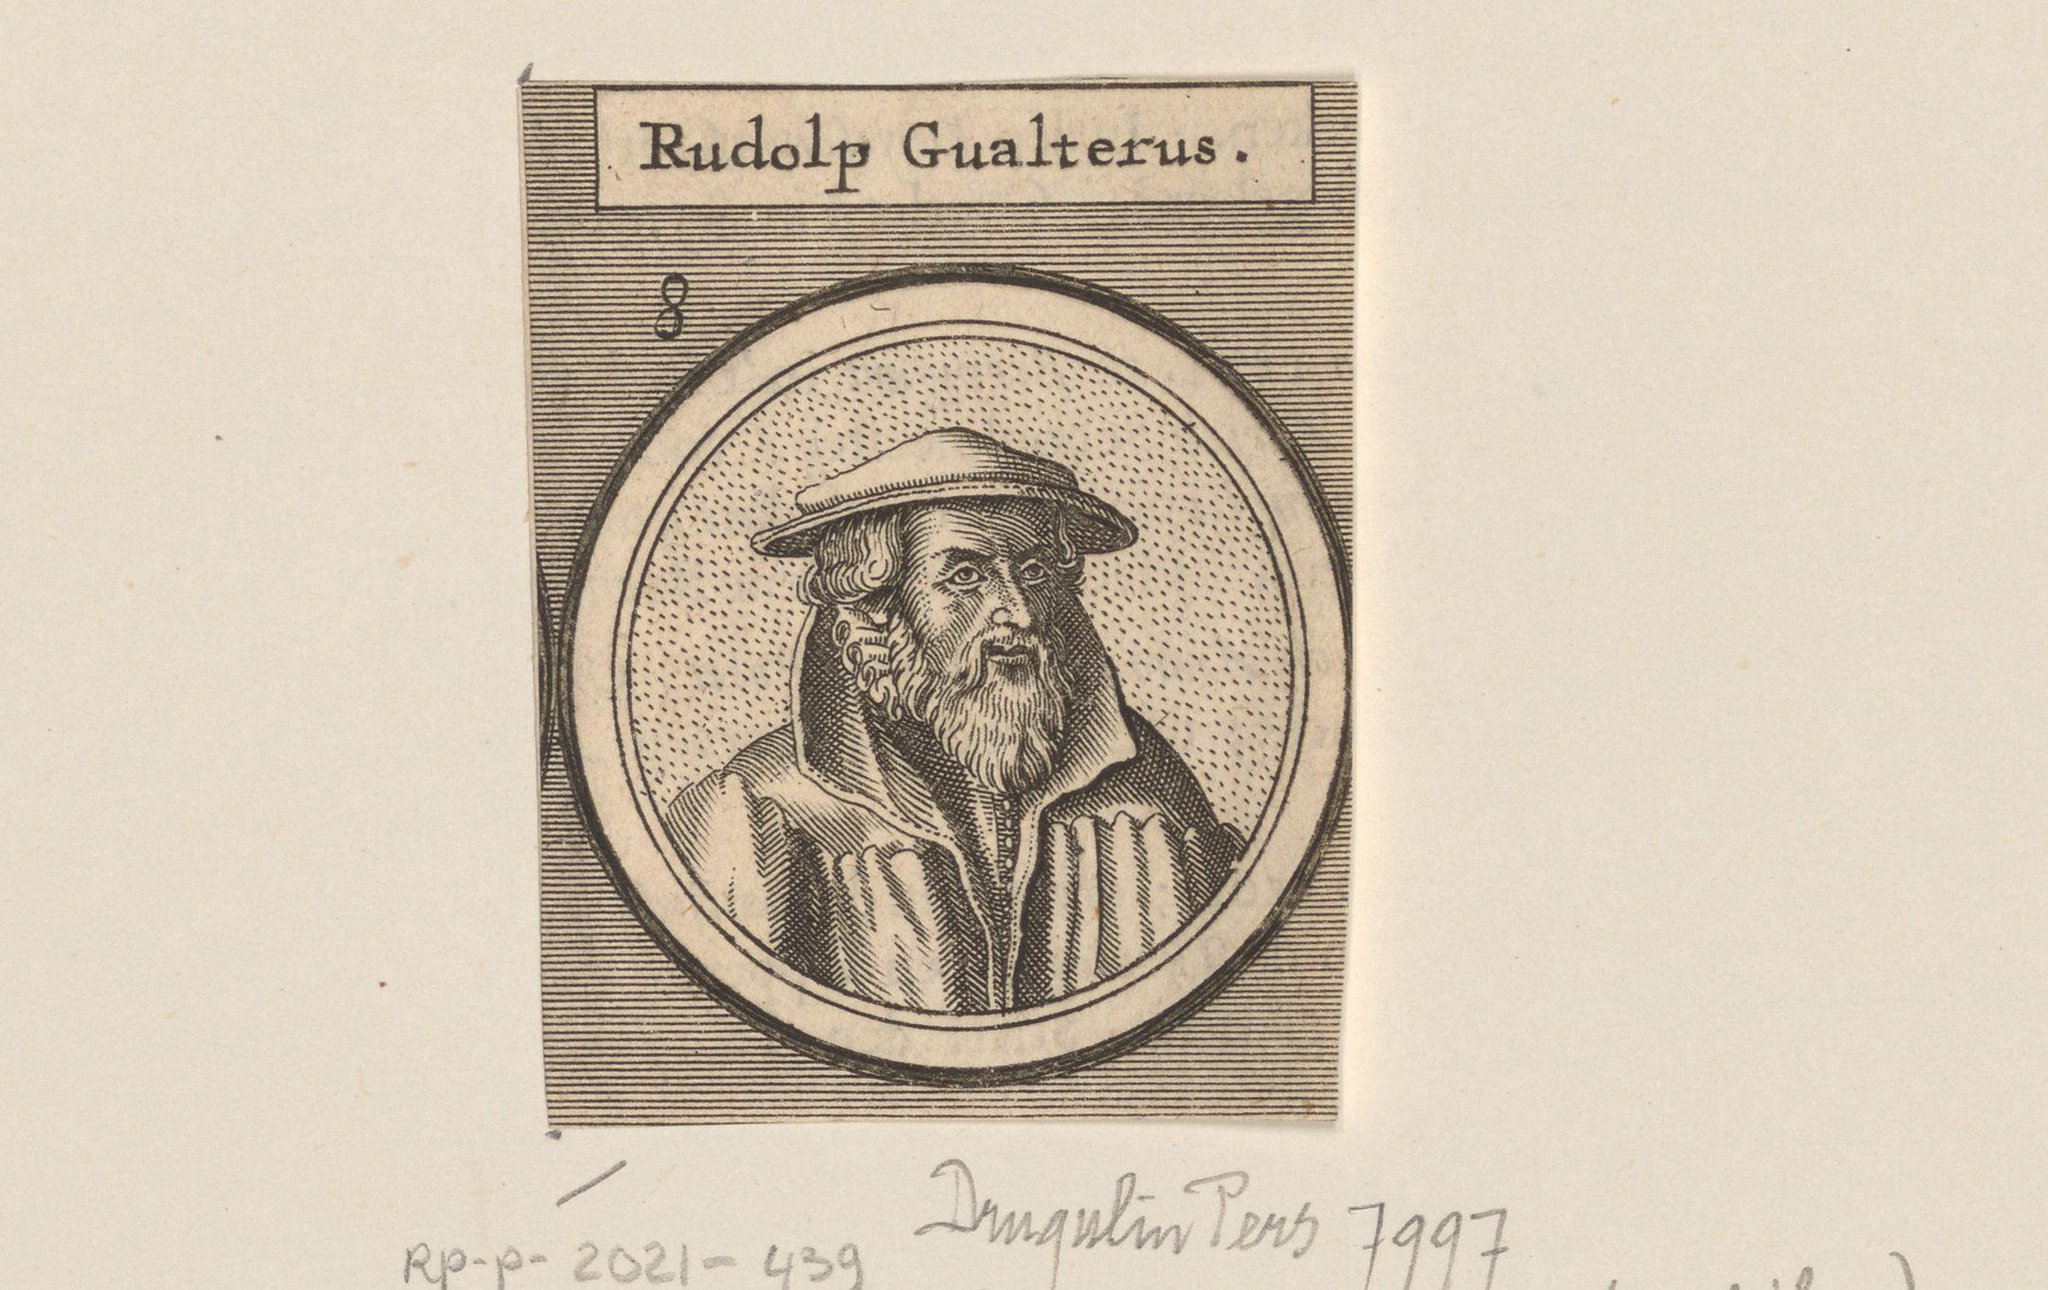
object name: book illustration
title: Portret van Rudolph Gwalther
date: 1698-1700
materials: paper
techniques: engraving, letterpress printing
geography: leiden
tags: theologian, historical persons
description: Prent uit: Gottfried, Johann Ludwig. Joh. Lodew. Gottfrieds Historische kronyck: vervattende ... der aldergedenkwaerdigste geschiedenissen van den aenvangh der scheppingh tot op 't jaer Christi 1576 : in een nette ordre gebragt na de verdeelingh van de vier monarchien, en de bondighste jaer-rekeningh. Leiden: Pieter van der Aa, 1696, dl. 1, tafel 16.